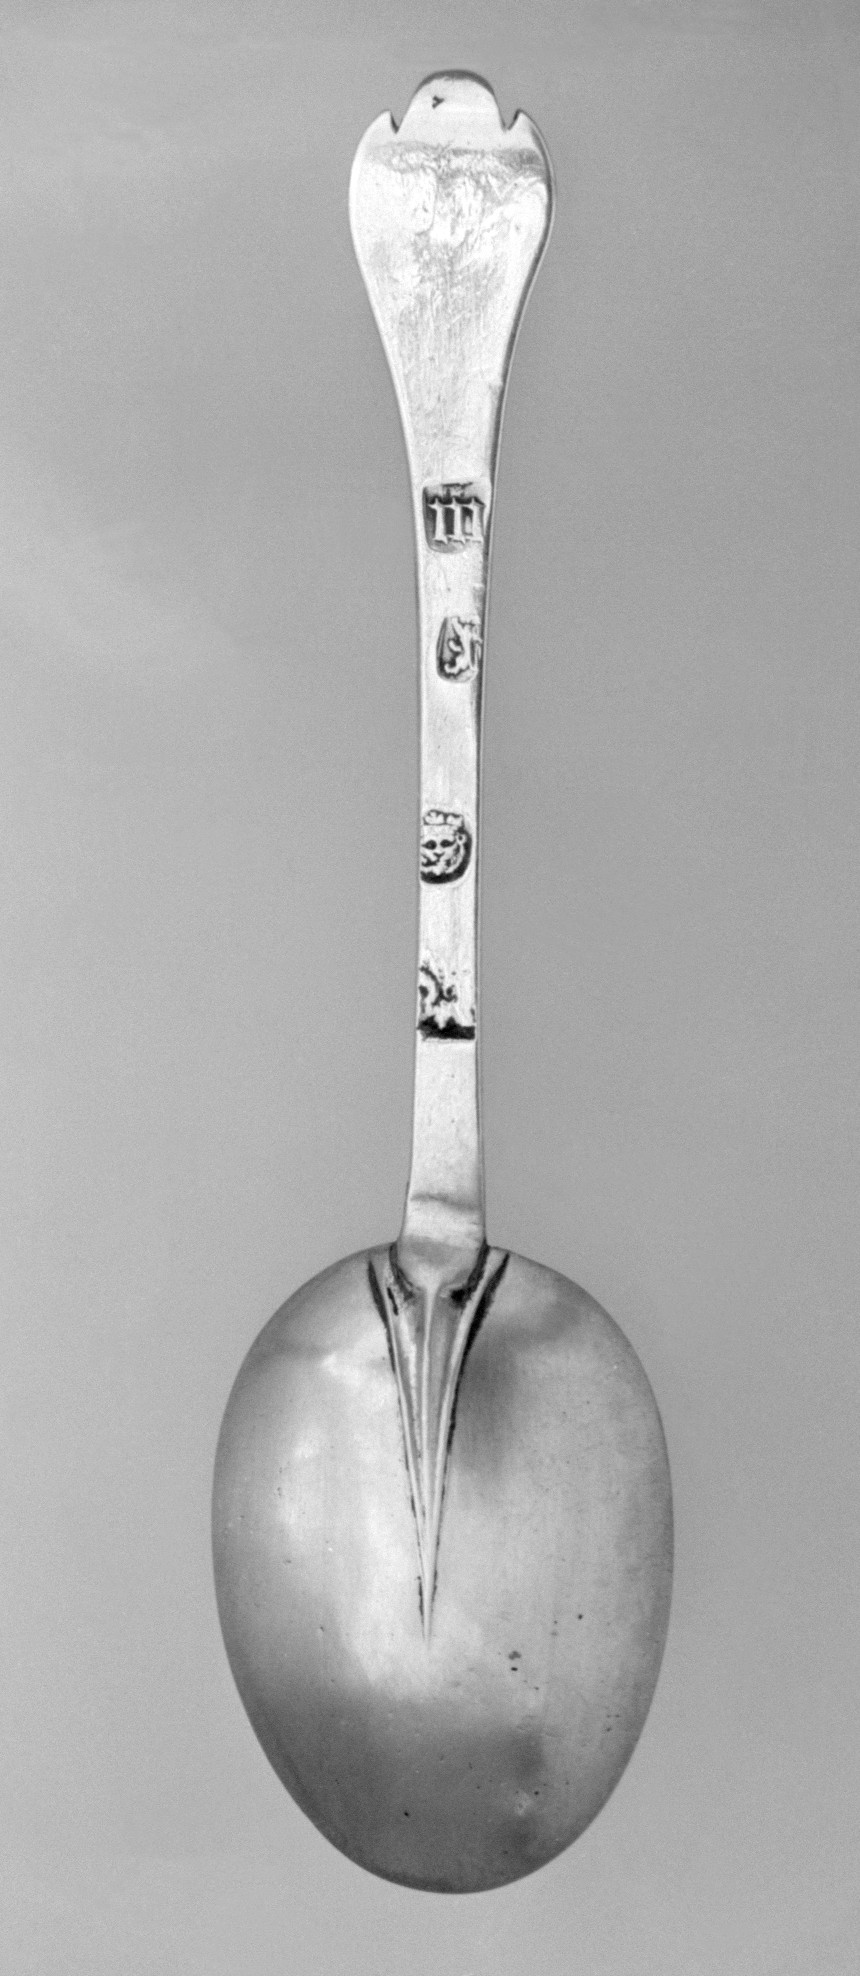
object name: spoon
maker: lawrence coles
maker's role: maker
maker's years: 1669-1714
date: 1689-1690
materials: silver